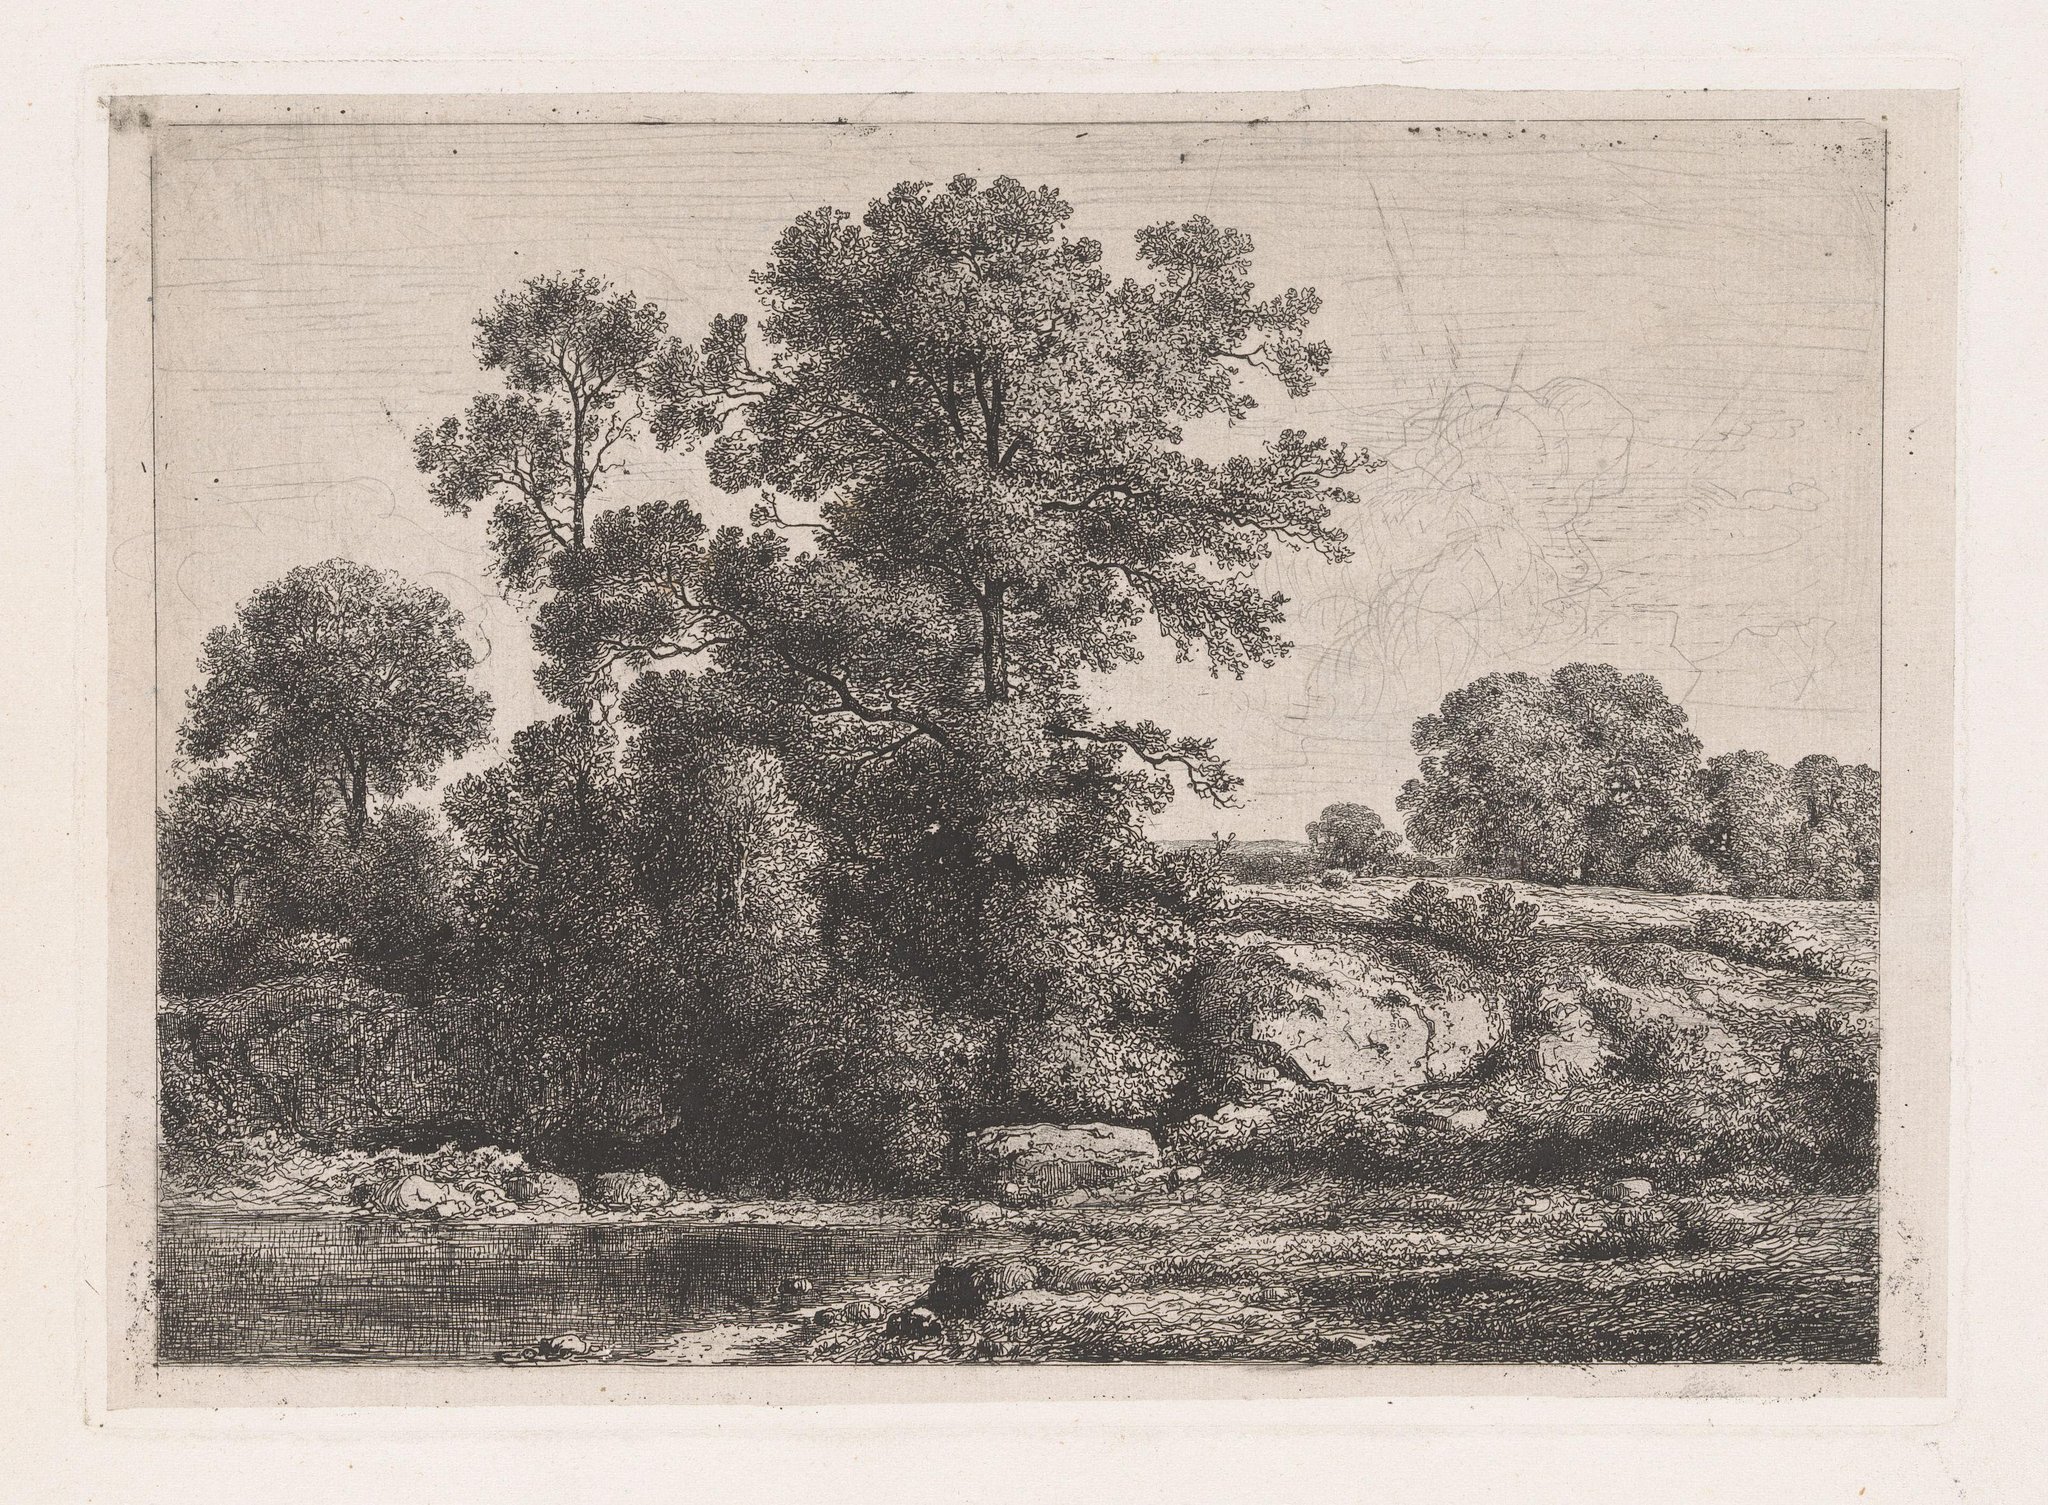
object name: print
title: Bomen aan de oever van een poel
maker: jean alexis achard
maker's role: print maker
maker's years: 1807-1884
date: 1817-1884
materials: paper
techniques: etching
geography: france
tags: trees, landscapes, pool, puddle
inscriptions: collector's mark: Lugt 2228, inscription: ‘2e état avant le changement du ciel / très rare tiré à quelques épreuves’